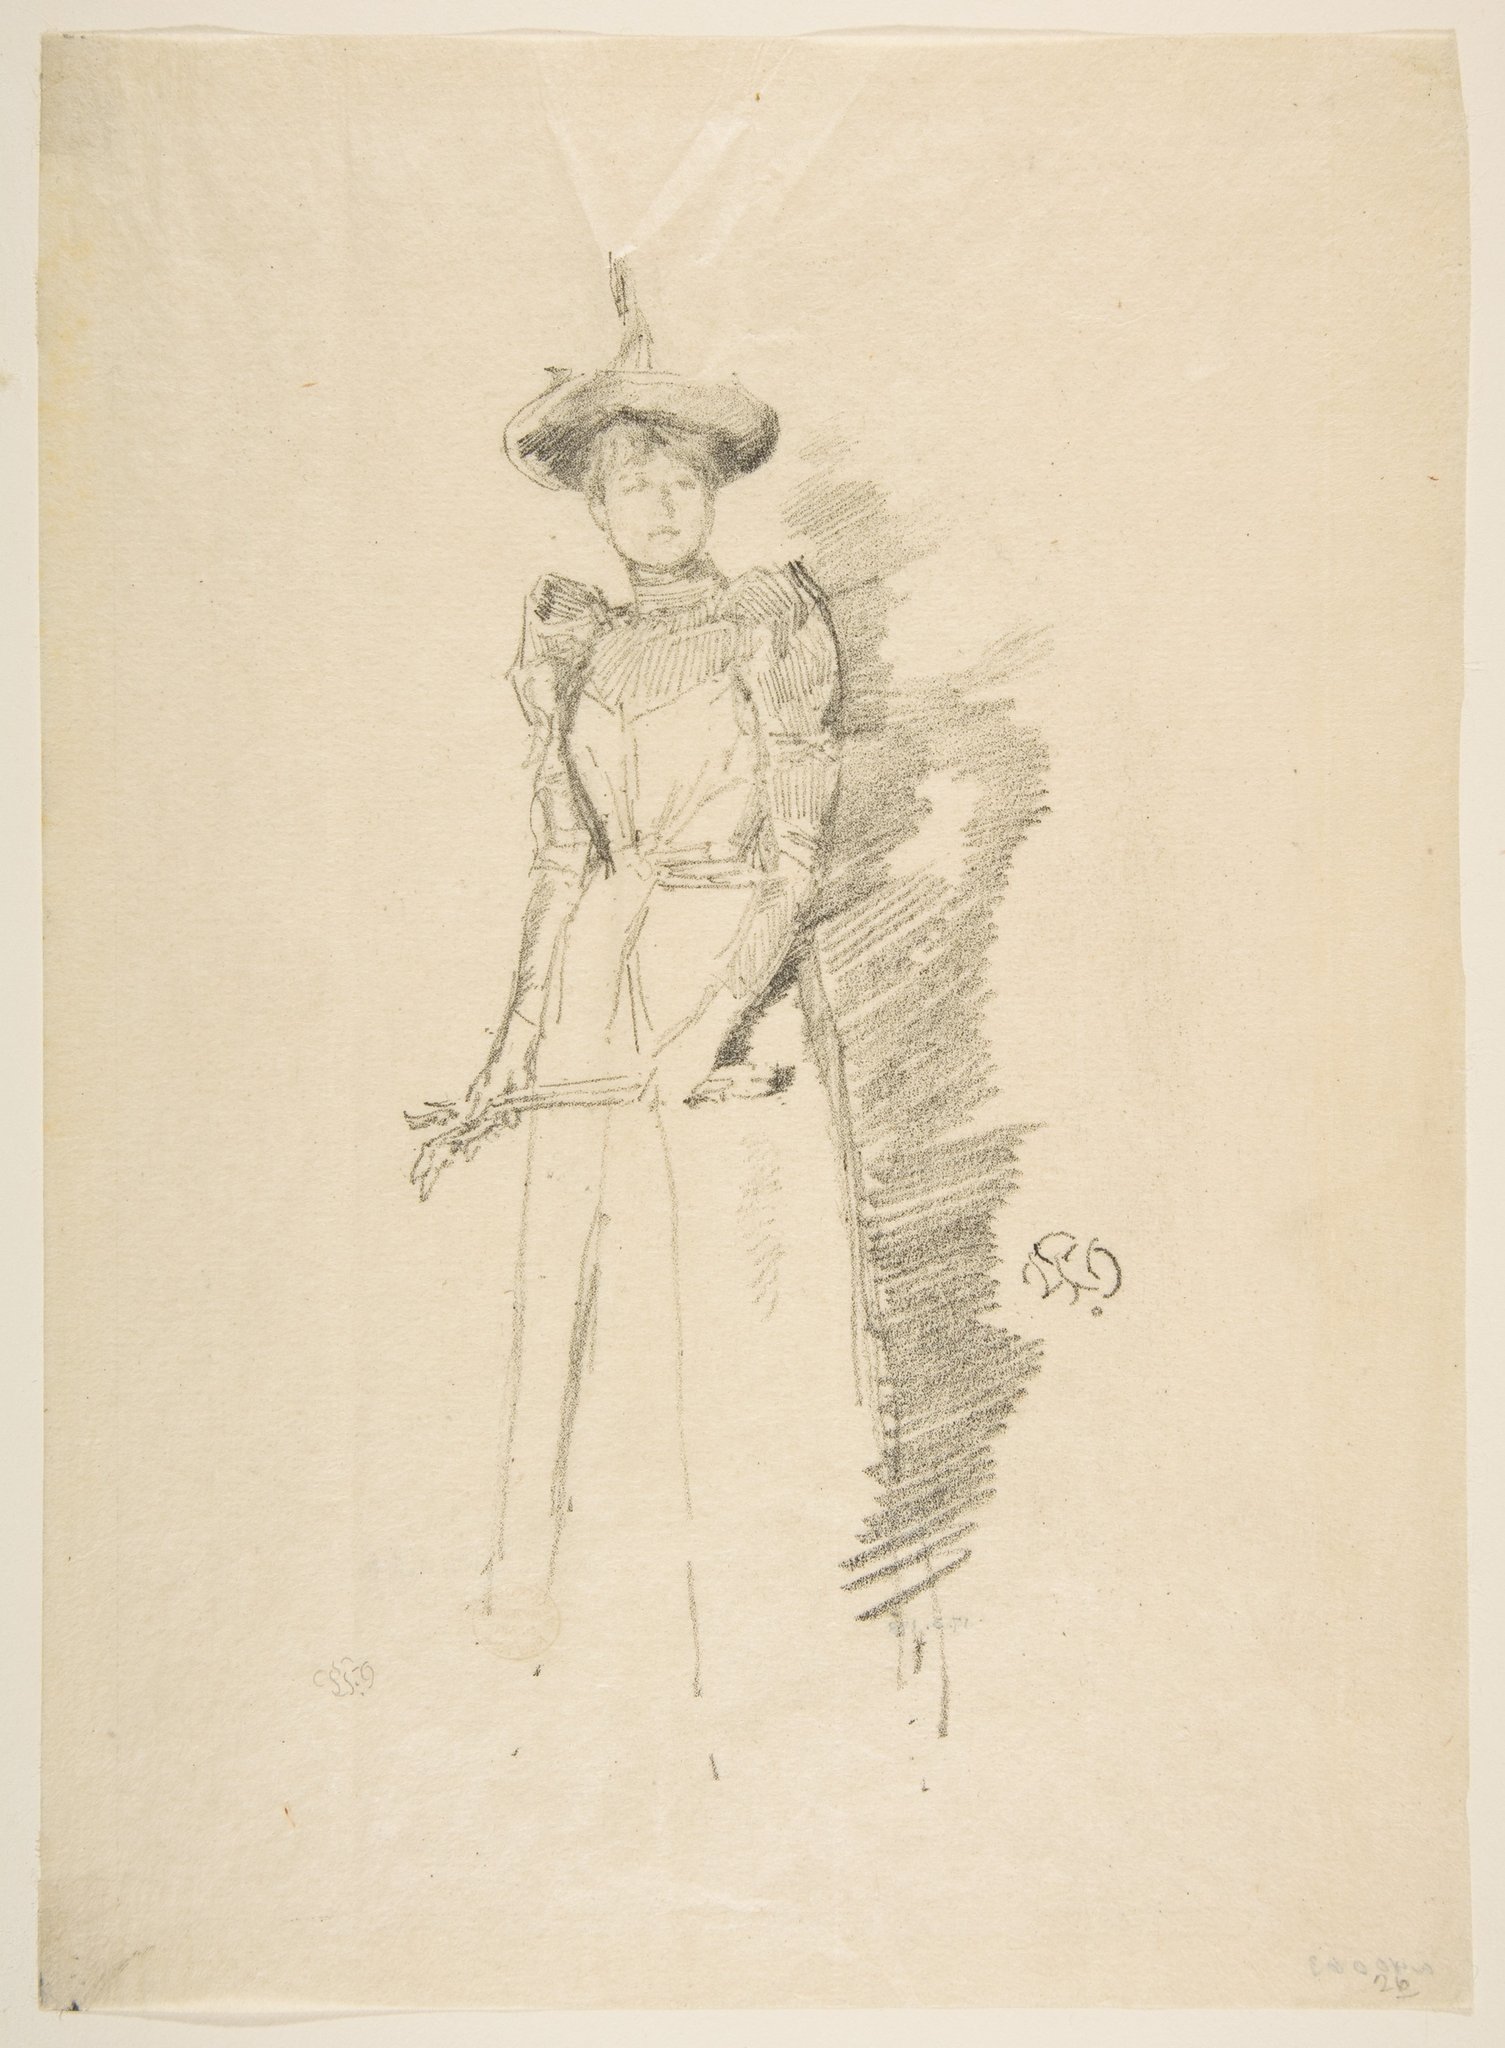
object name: print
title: Gants de Suède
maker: james mcneill whistler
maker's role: artist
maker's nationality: american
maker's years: 1834-1903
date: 1890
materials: ink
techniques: printing, lithography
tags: women